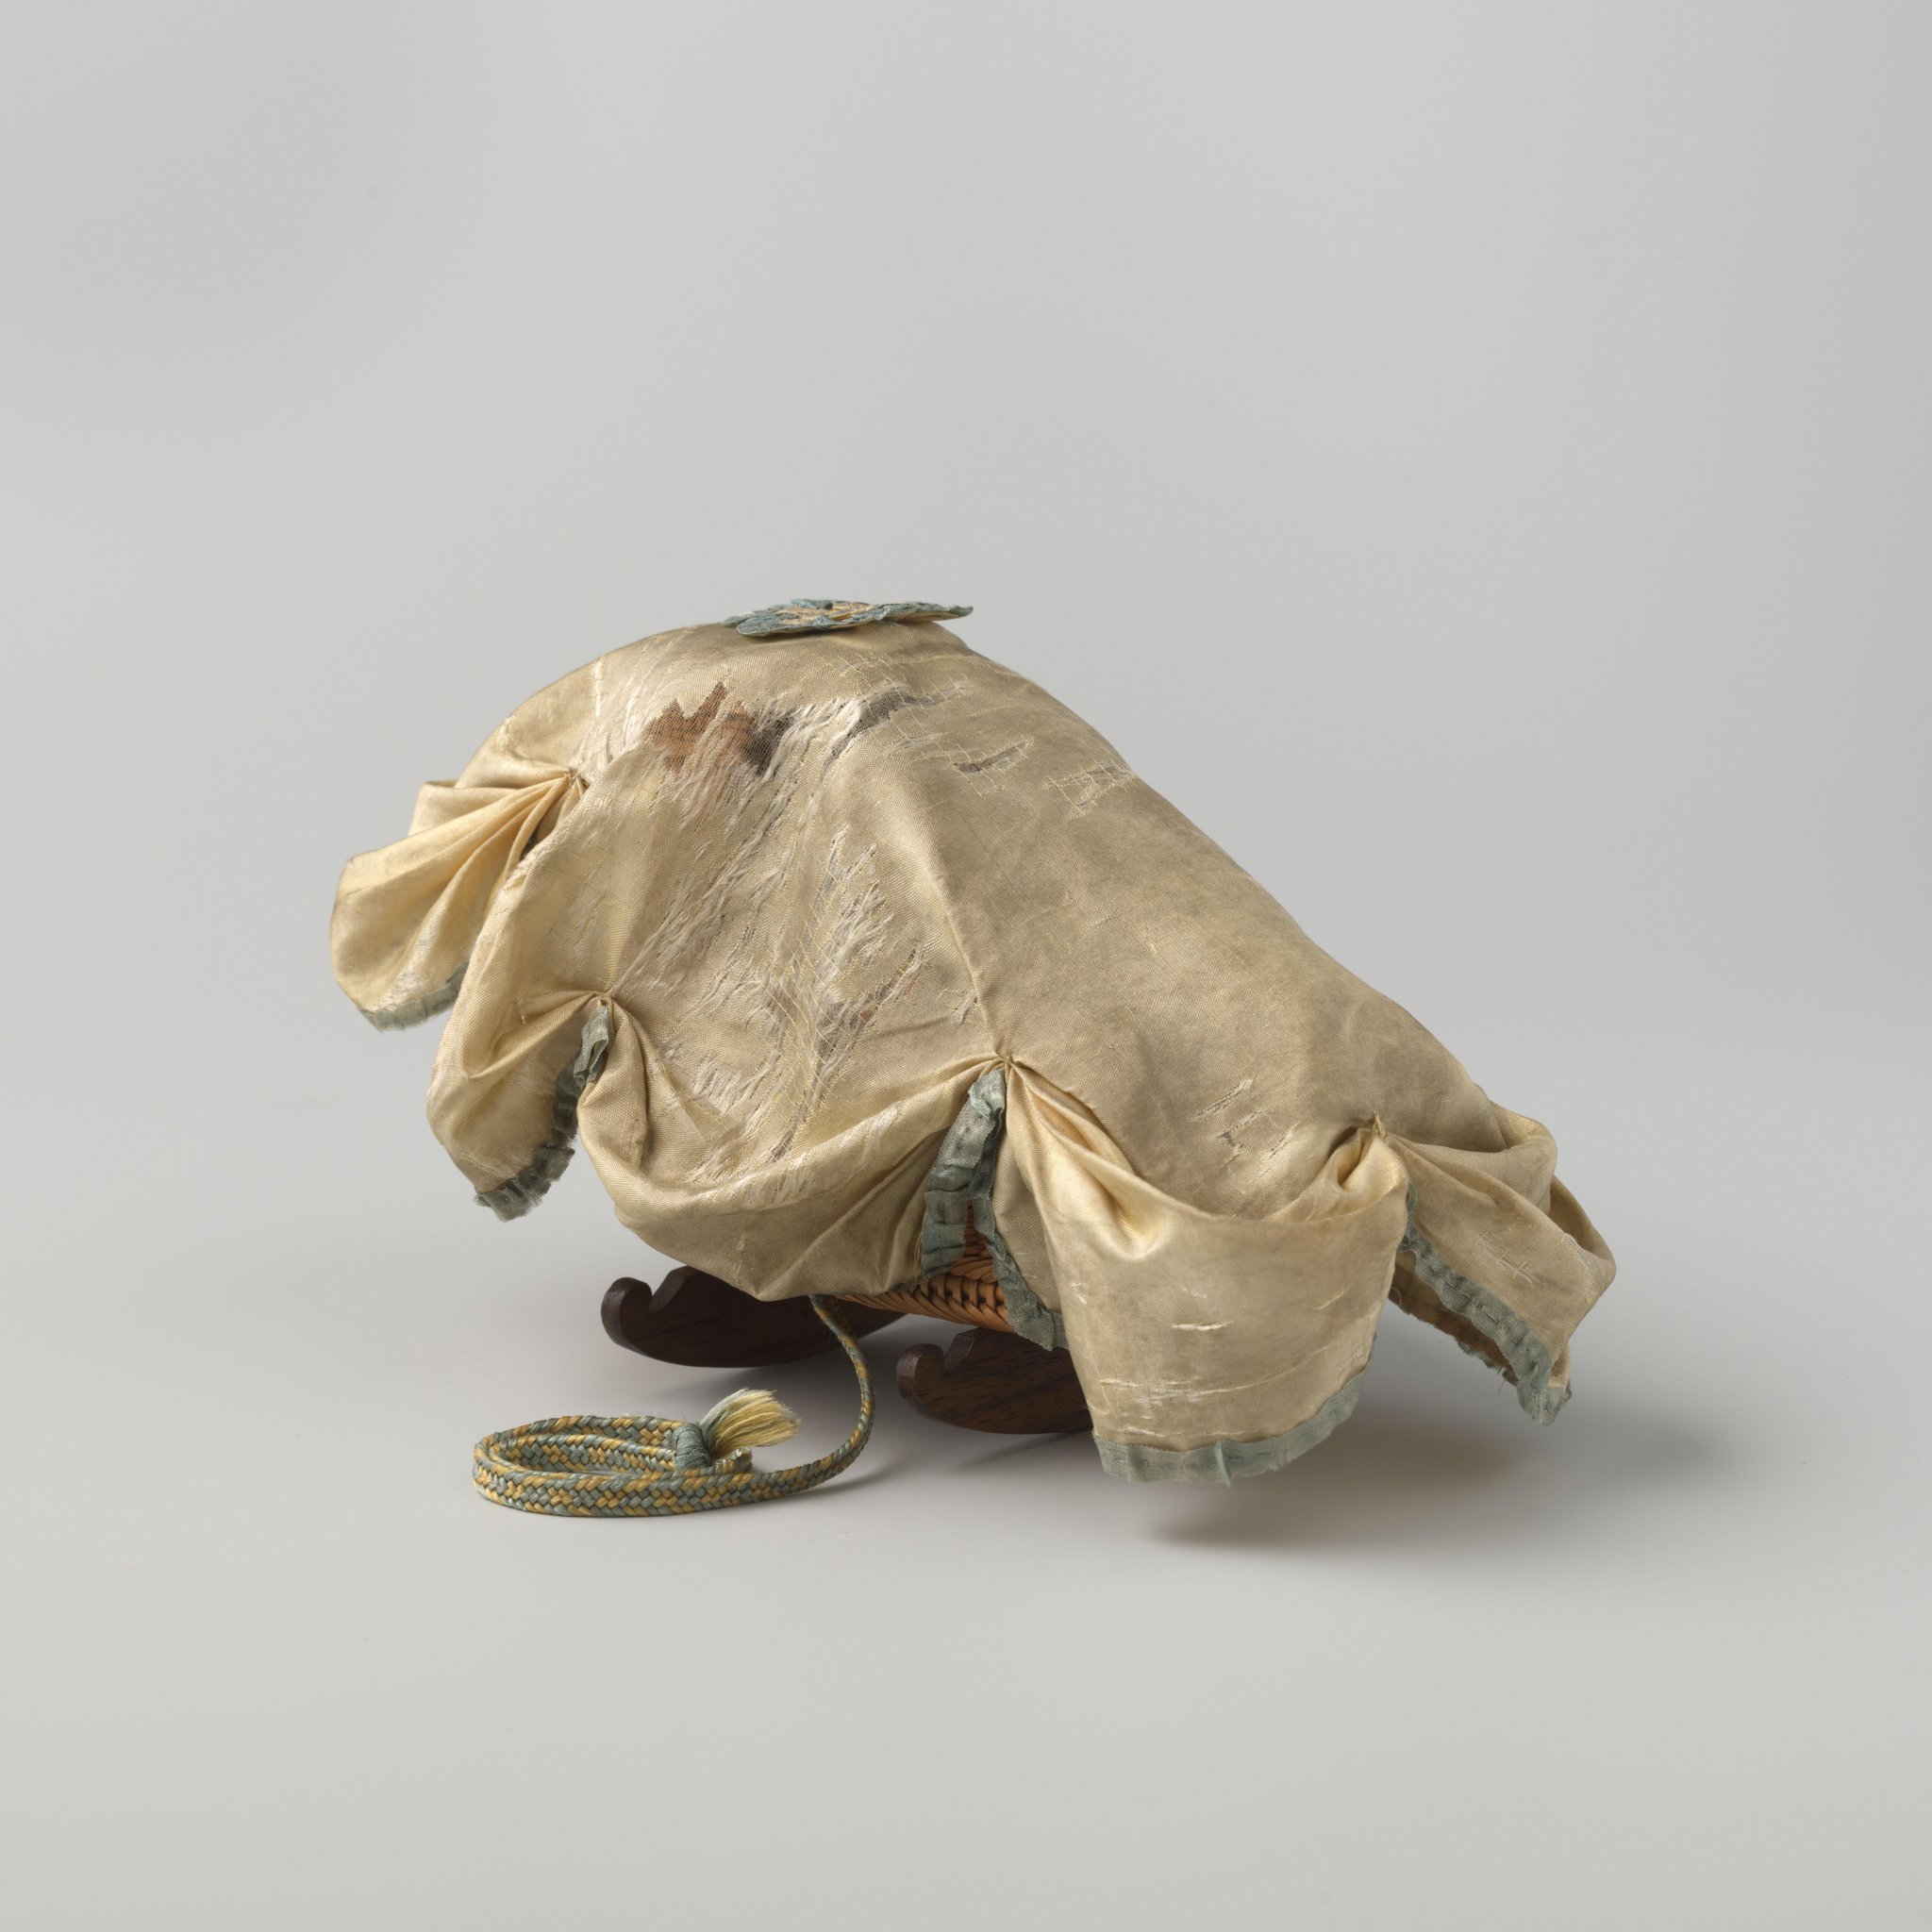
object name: miniature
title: Wiegenkleed, gemaakt van licht gele zijde, afgezet met een ingerimpeld blauw zijden lintje.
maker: Anonymous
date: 1690-1710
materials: silk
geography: amsterdam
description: Wiegekleed, gemaakt van licht gele zijde, afgezet met een ingerimpeld blauw zijden lintje. Het kleed is geconstrueerd uit een rechthoekige lap stof, waarvan de randen op acht plaatsen zo zijn opgenomen en in ploeien vastgezet, dat een bolle wiegvorm is ontstaan met draperieën. boven op de kap is een rozet genaaid van dezelfde stof met blauw lint. Het kleed is op de wieg bevestigd met een blauwe strik onder de kap (nu los aangezet).